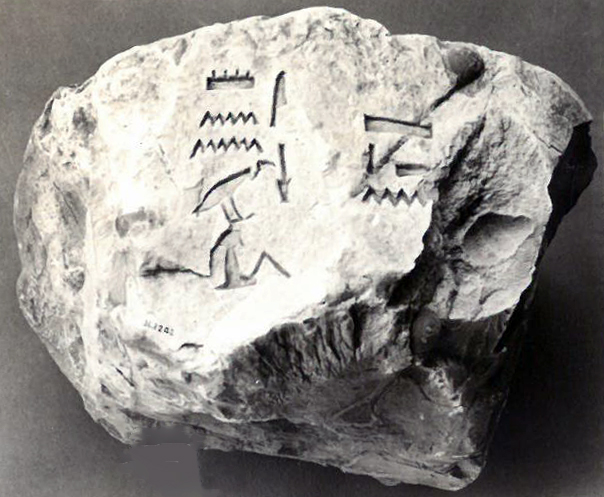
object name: name stone, tally, senenmut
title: Name Stone of Senenmut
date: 1479-1458 BCE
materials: limestone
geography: egypt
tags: hieroglyphs